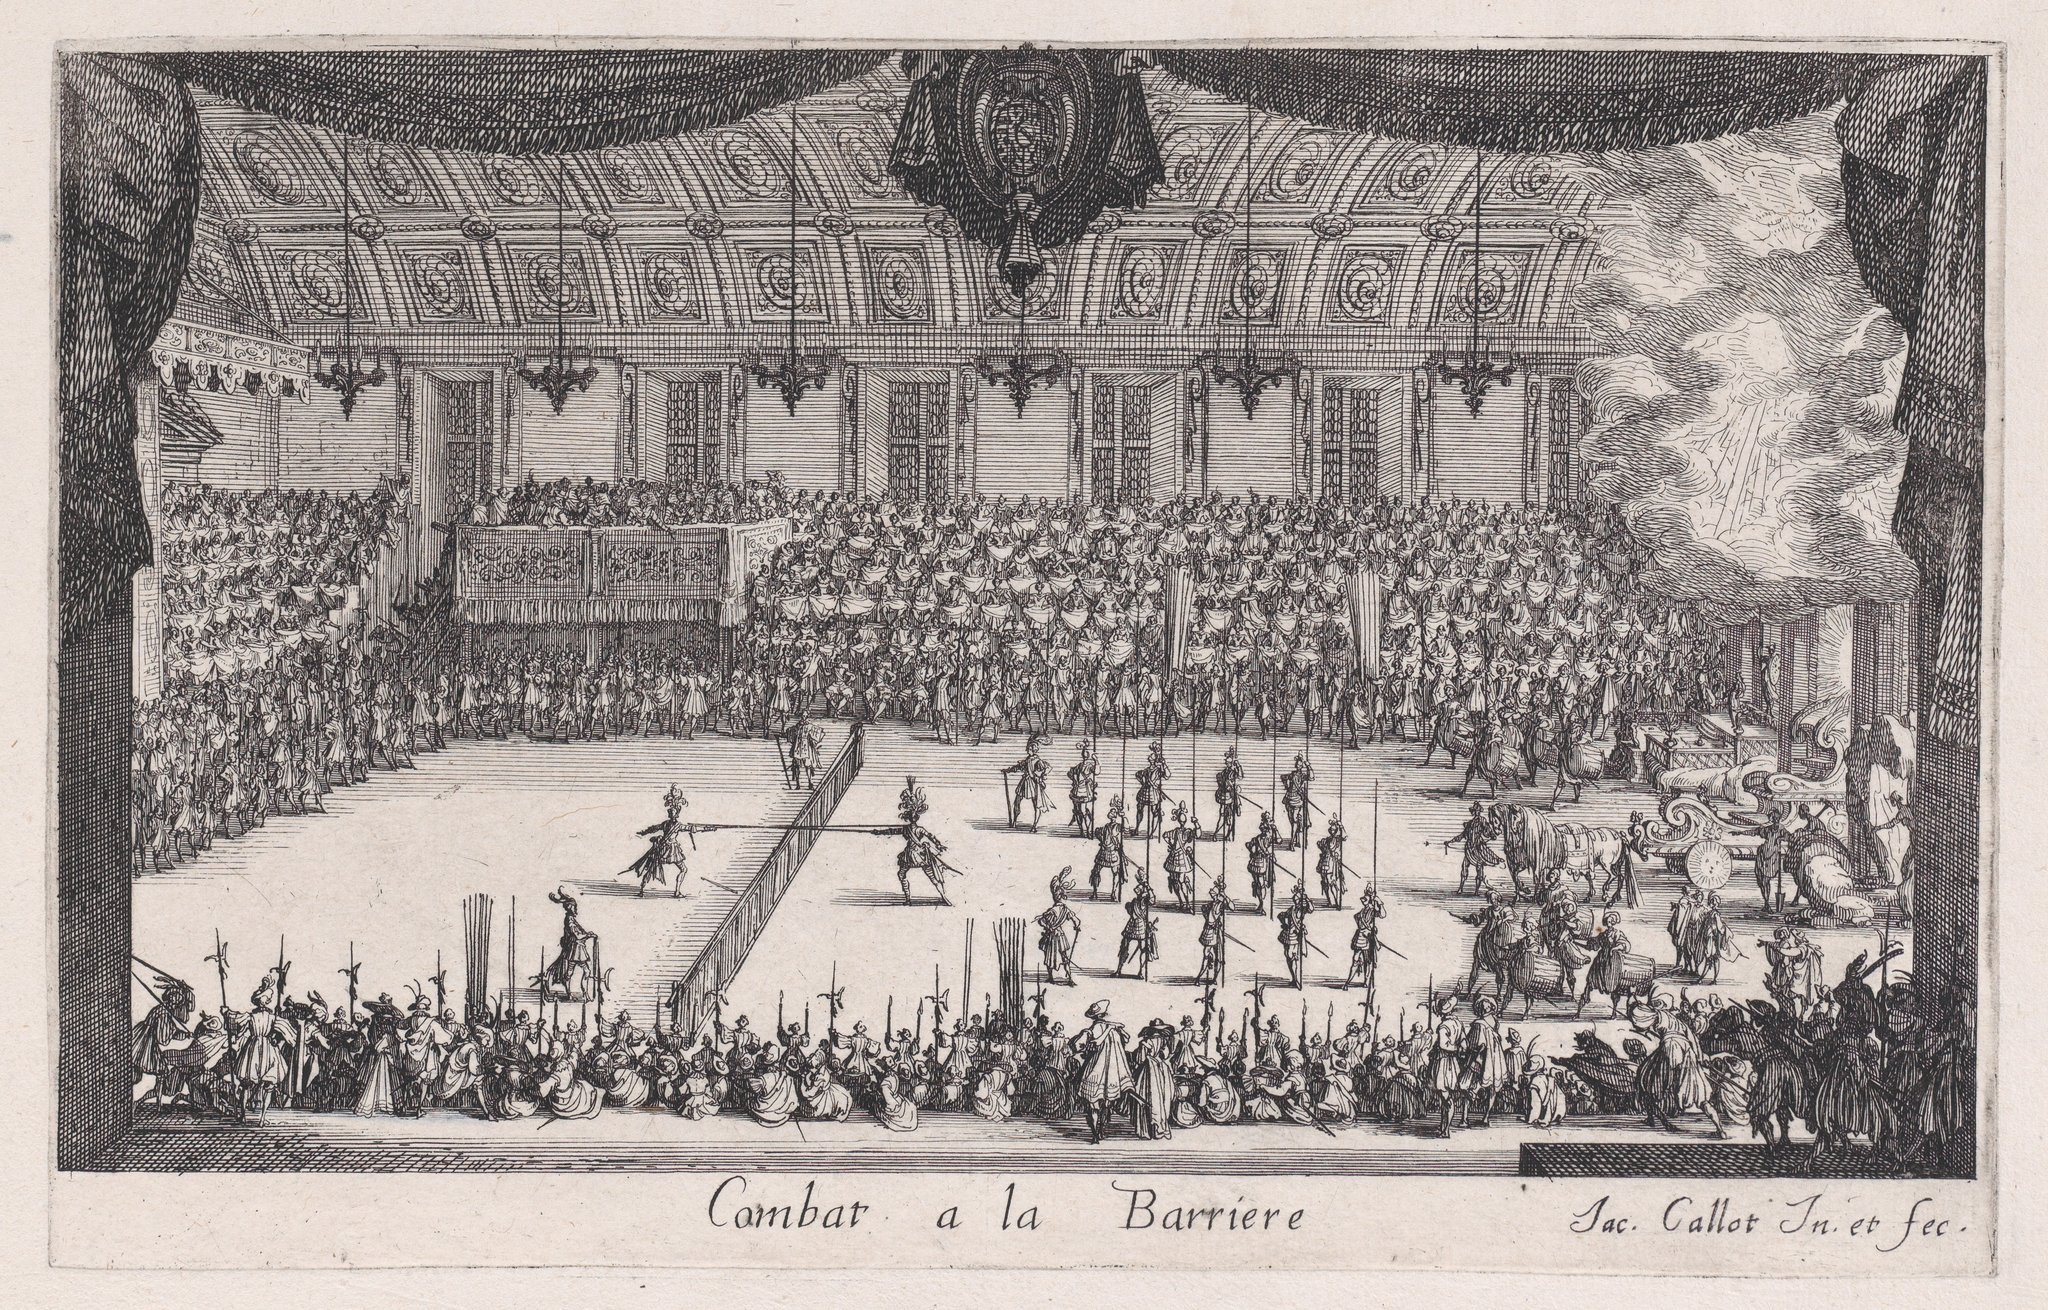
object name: print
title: Le Combat (The Combat), from "Le Combat a la Barrière"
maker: jacques callot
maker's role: artist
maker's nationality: french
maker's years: 1592-1635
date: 1627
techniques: etching